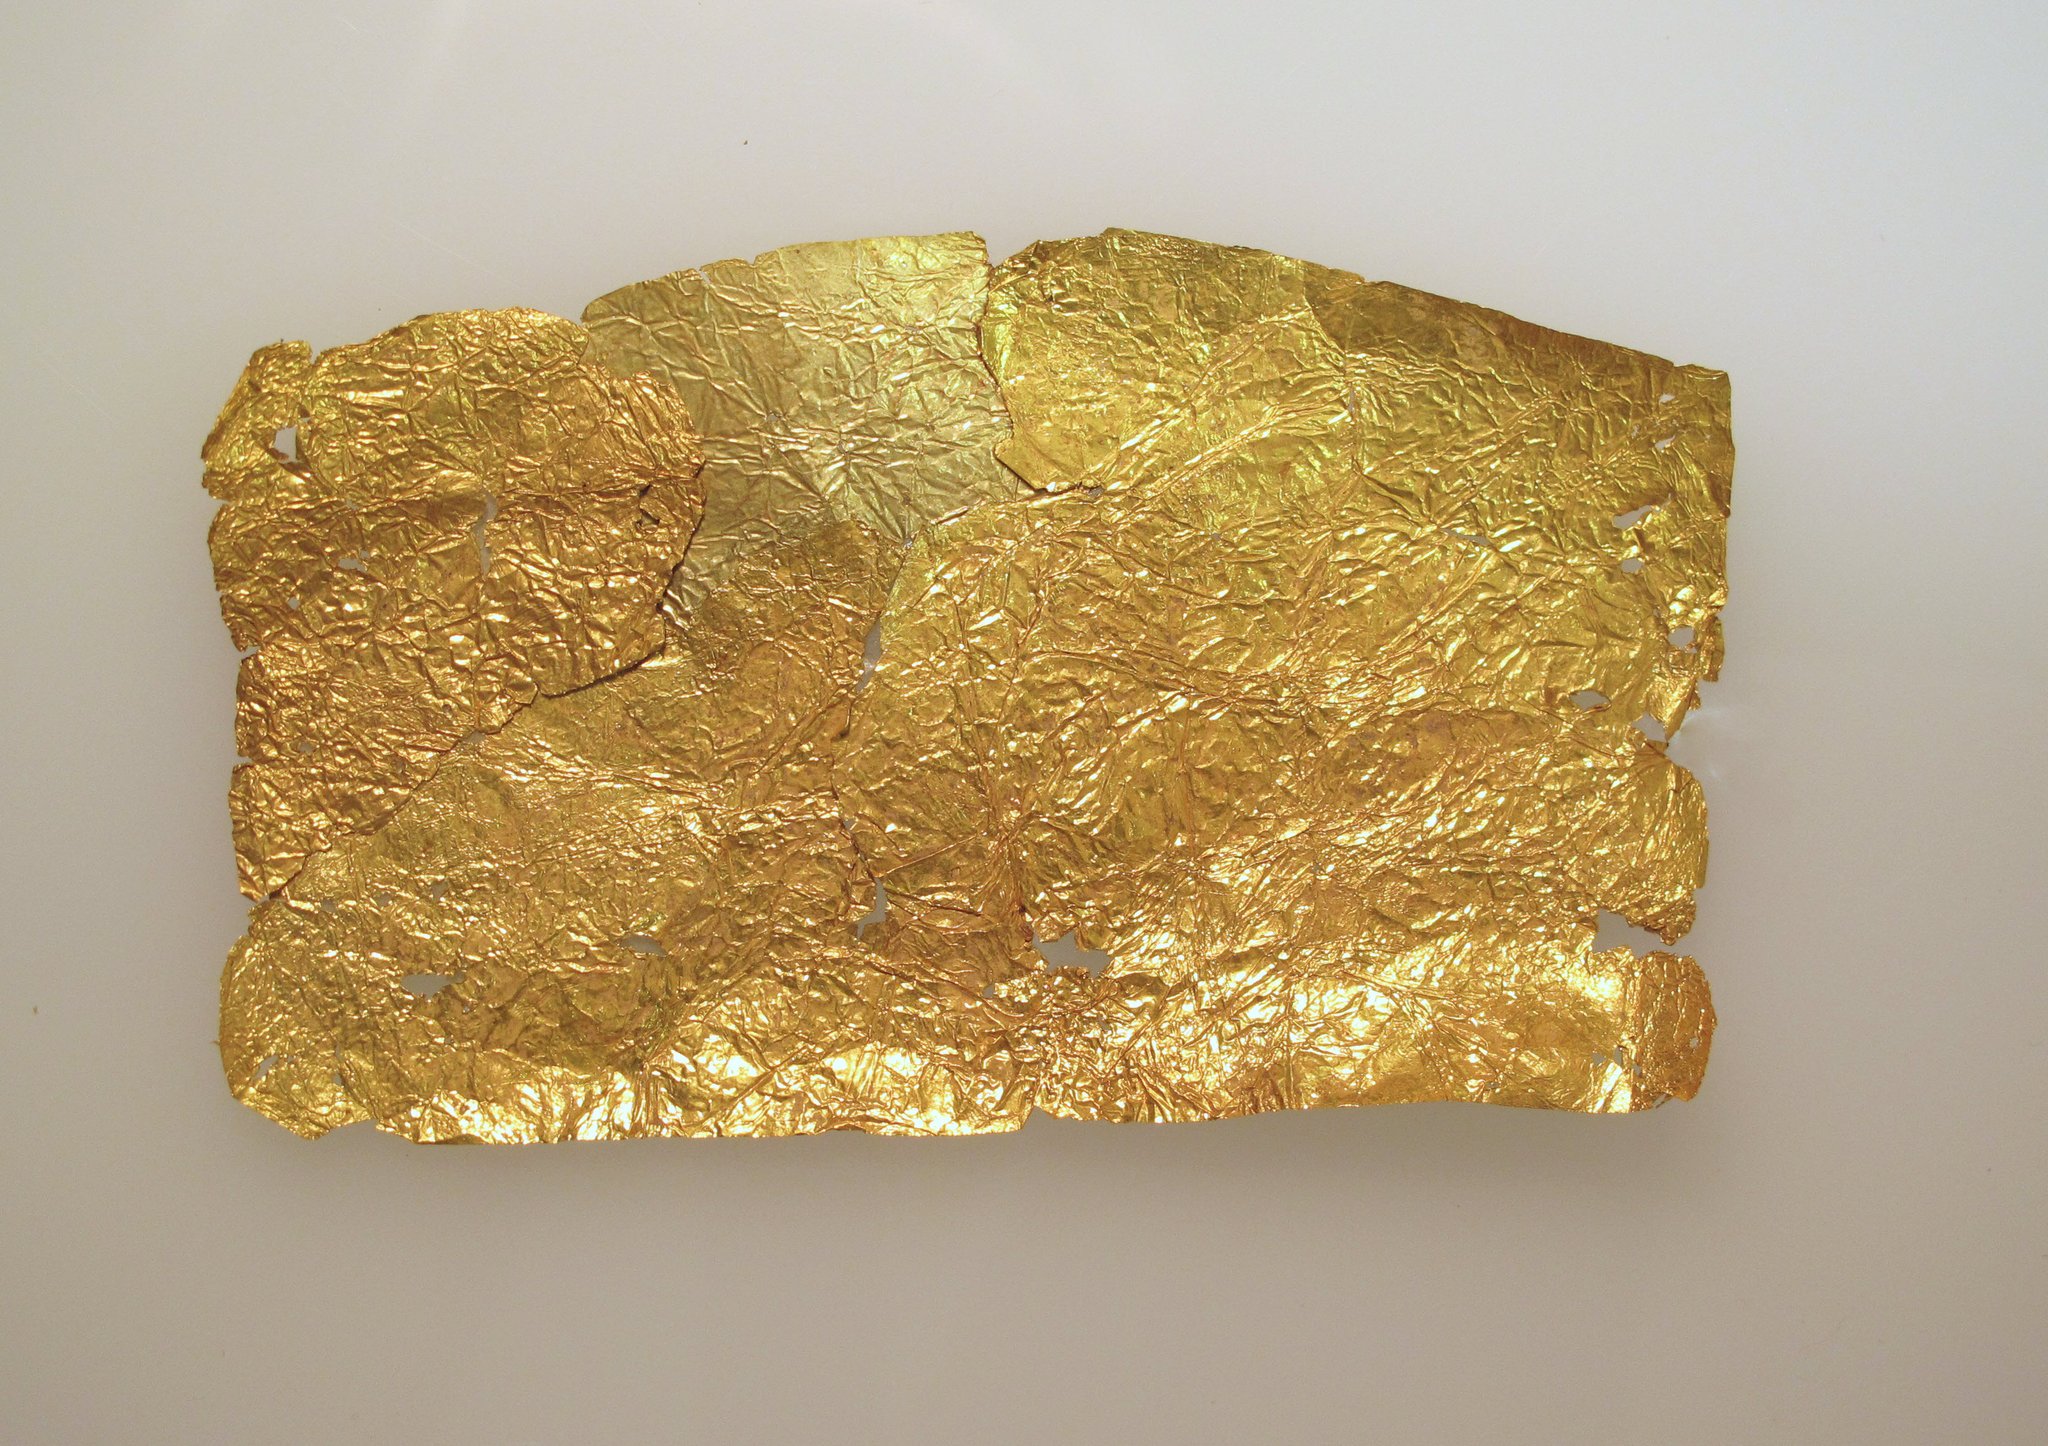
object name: frontlet of gold leaf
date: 7000 BCE-330 CE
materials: gold